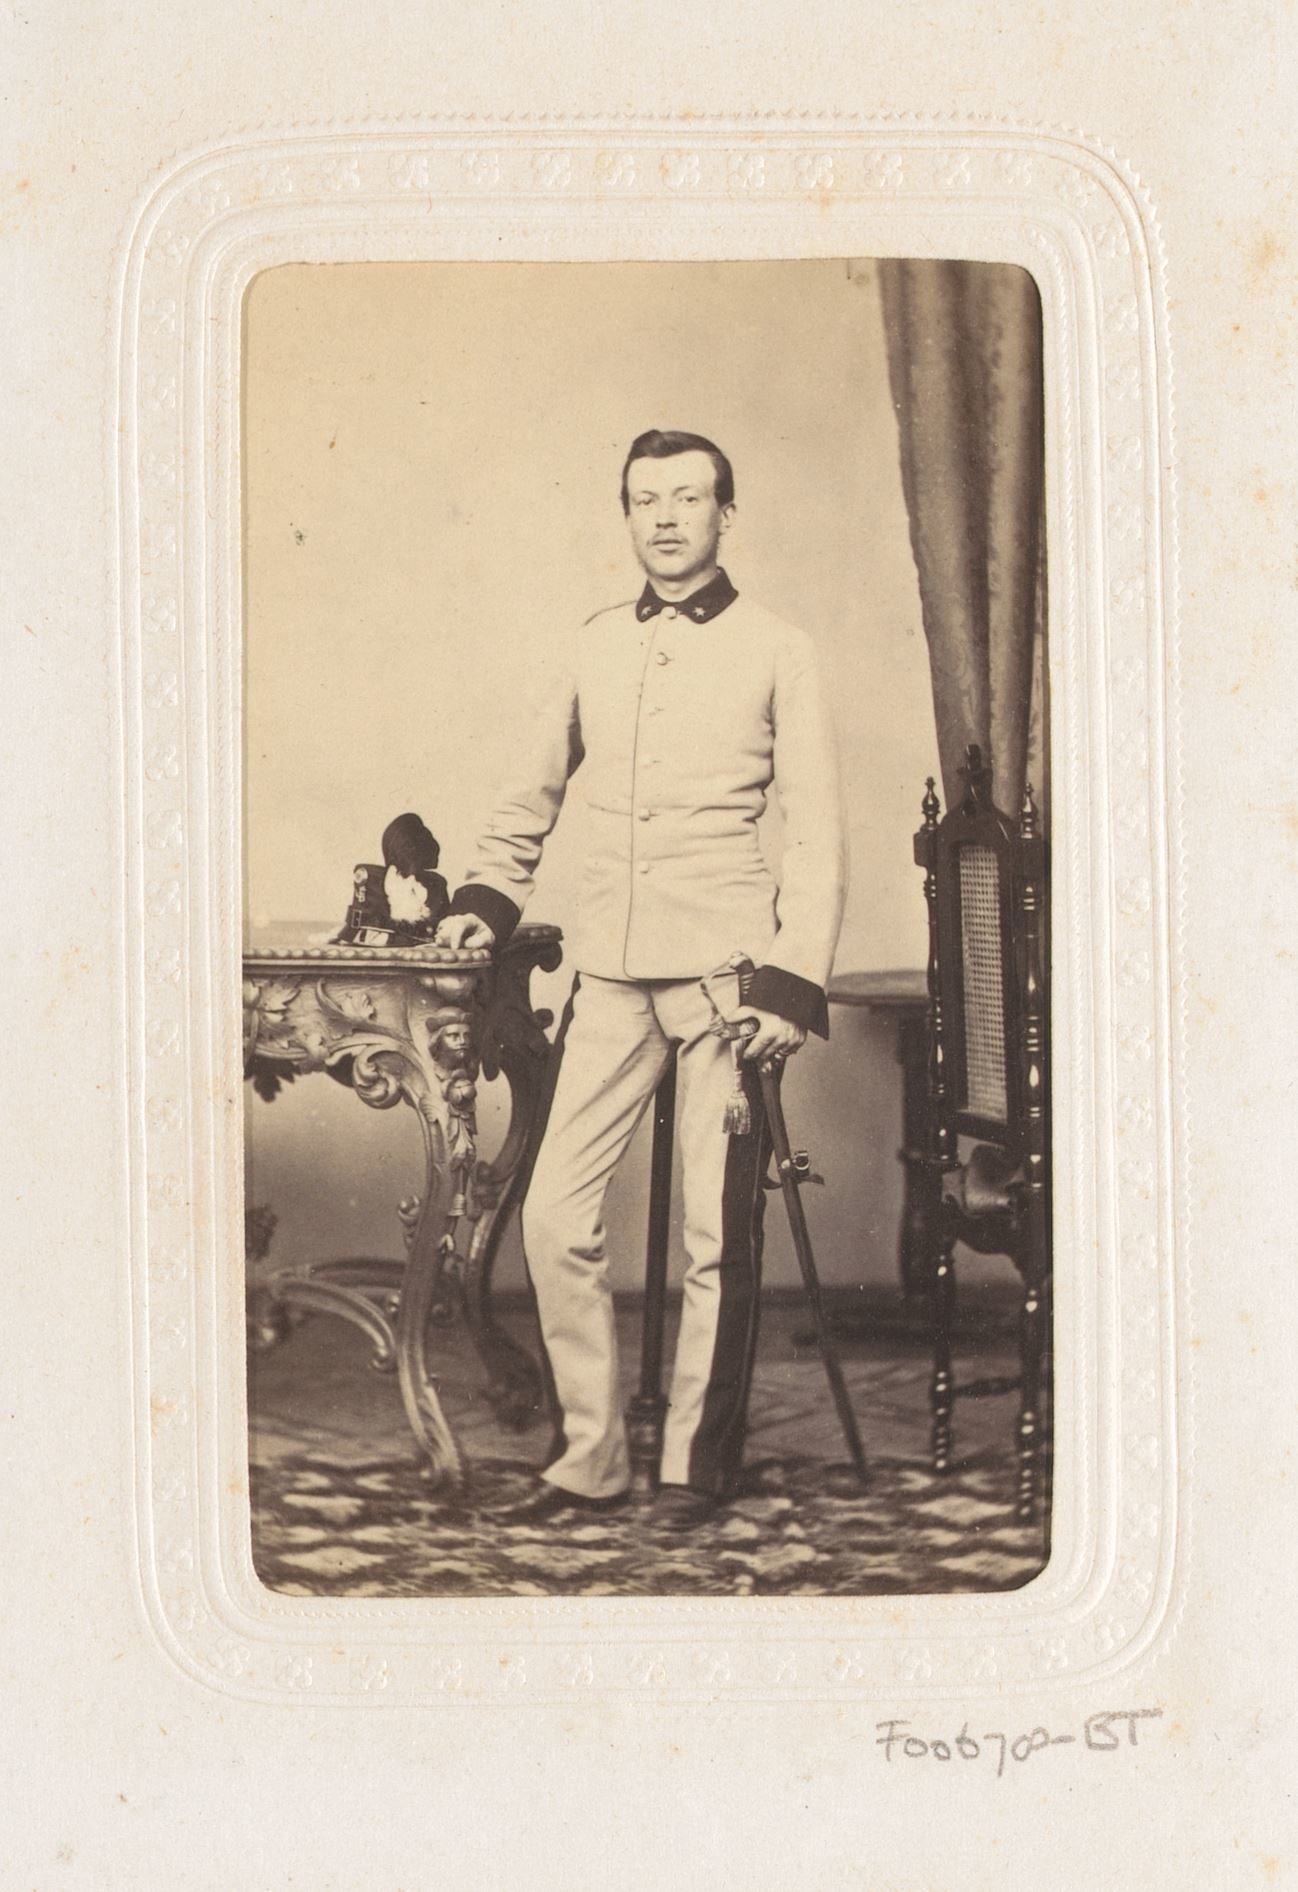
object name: carte de visite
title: Portret van een staande militair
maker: b. joseph fechner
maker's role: fotograaf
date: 1860-1880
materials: cardboard, photographic support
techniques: albumen print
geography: vienna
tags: historical persons, (military) uniforms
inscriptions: inscription: ‘Photografie/ B. Jos. Fechner/ Wien/ Verlängerte Kärntnerstrasse/ Eck der Elisabeth-Strasse/ No1 neu N1271 alt’